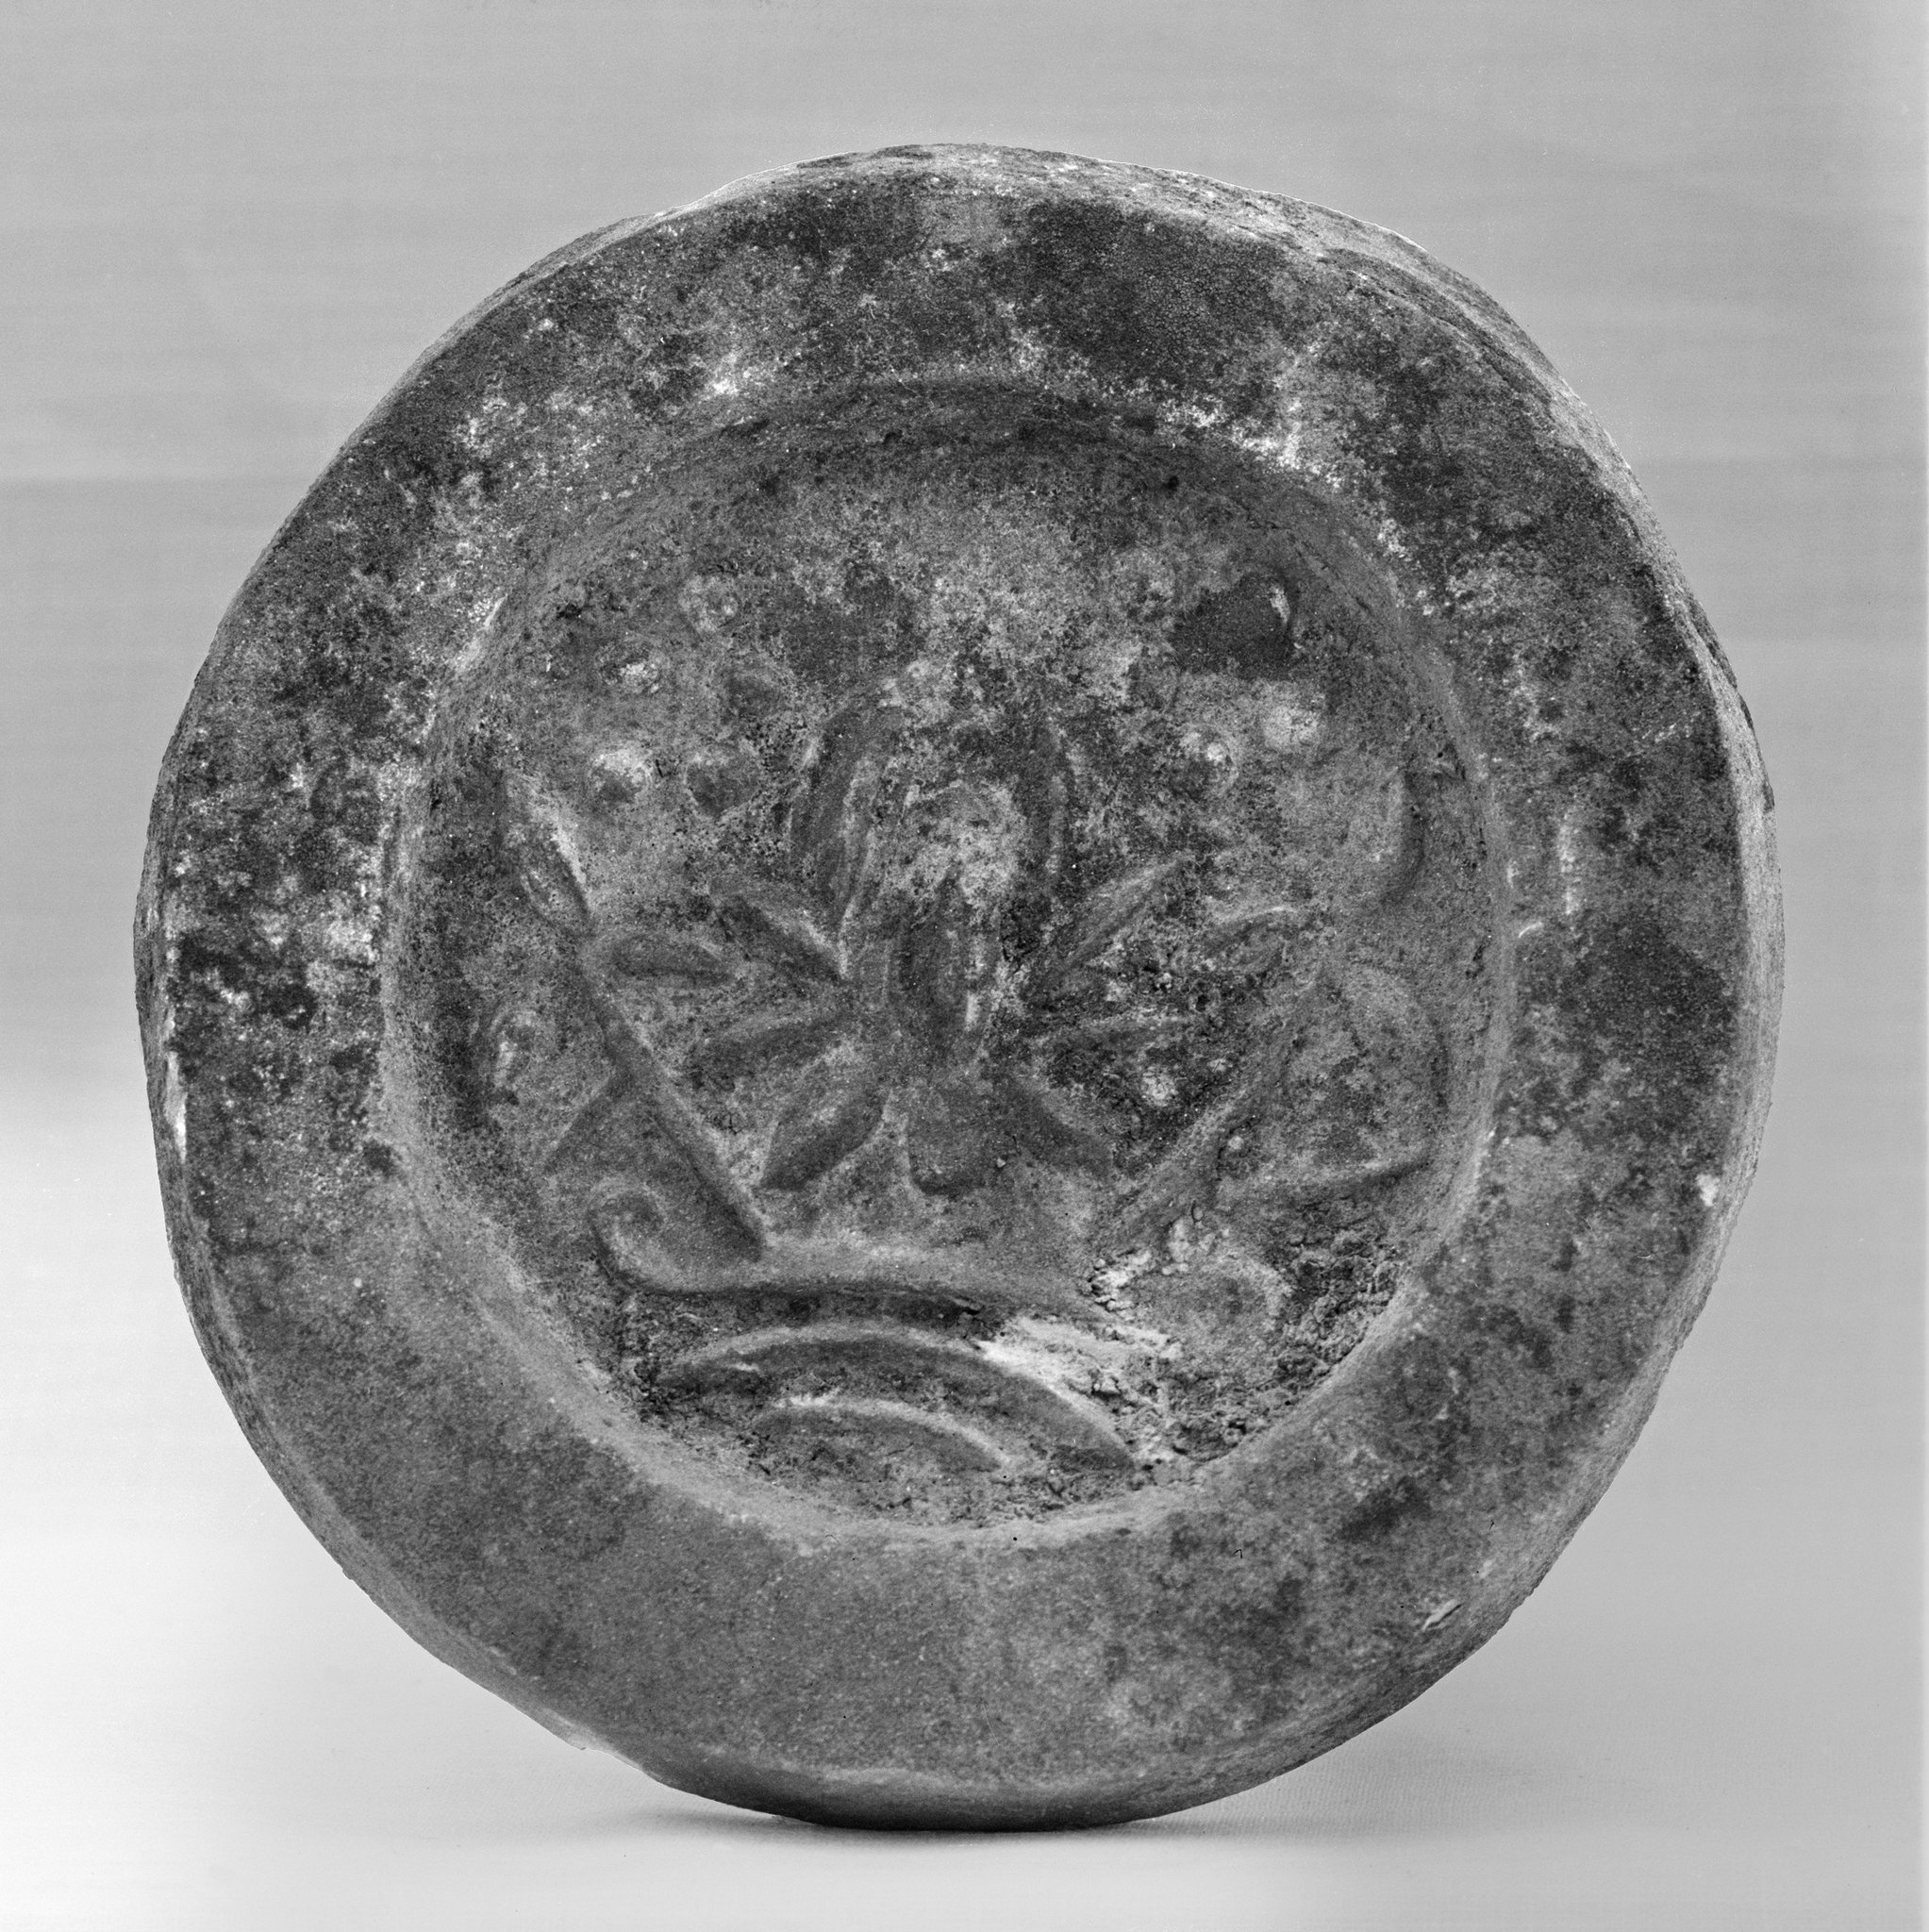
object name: tile end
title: Tile end with lotus flower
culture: chinese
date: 1501-1700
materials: earthenware